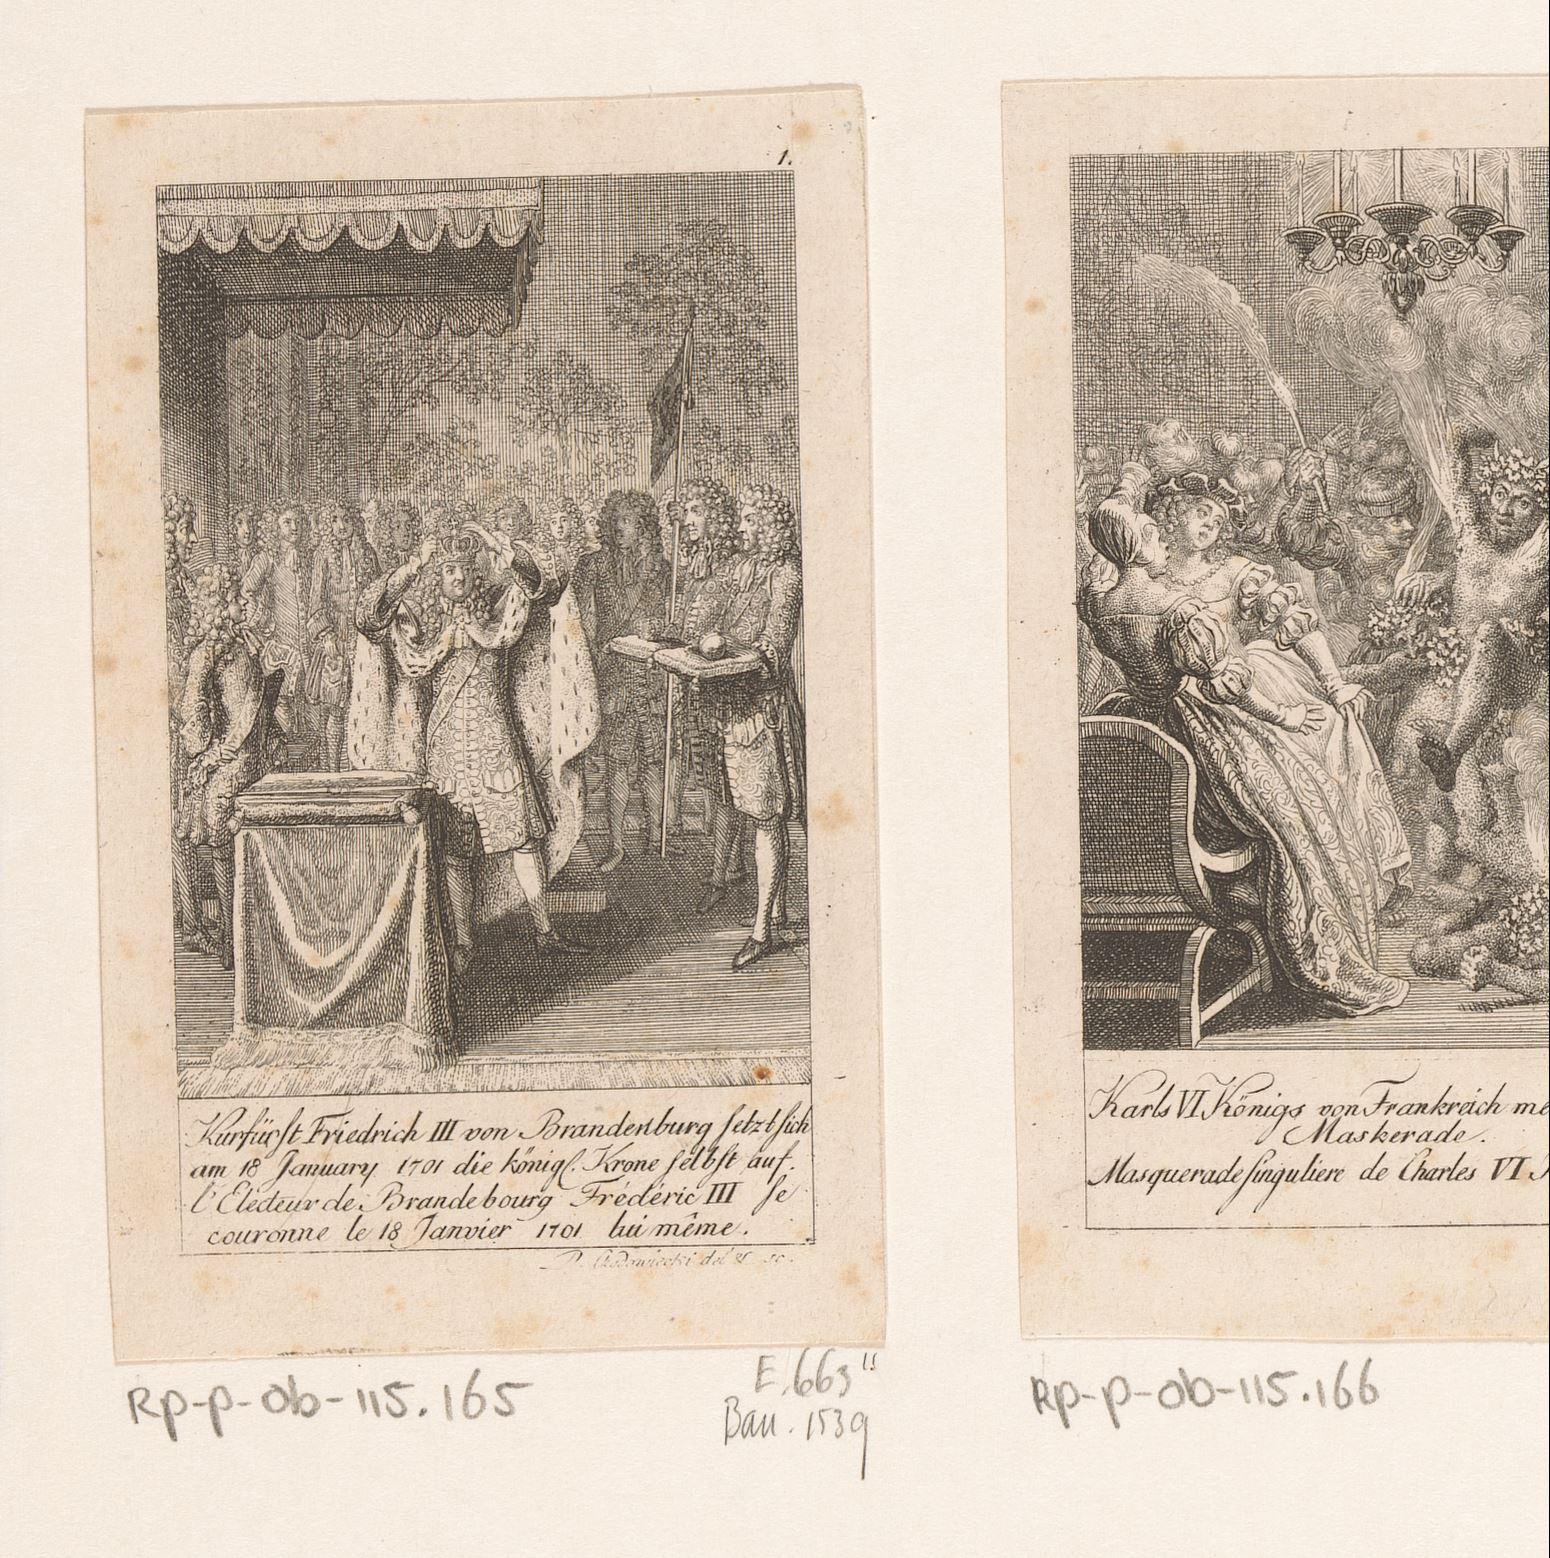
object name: print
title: Frederik III kroont zichzelf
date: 1791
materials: paper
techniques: etching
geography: berlin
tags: berlin, frederik i koning van pruisen, crown (symbol of sovereignty), history, during the coronation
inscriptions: collector's mark: Lugt 2228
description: Prent gebruikt voor: Gothaischer Hof Kalender, zum Nutzen und Vergnügen auf das Jahr 1792. Gotha: C. W. Ettinger, [1791].